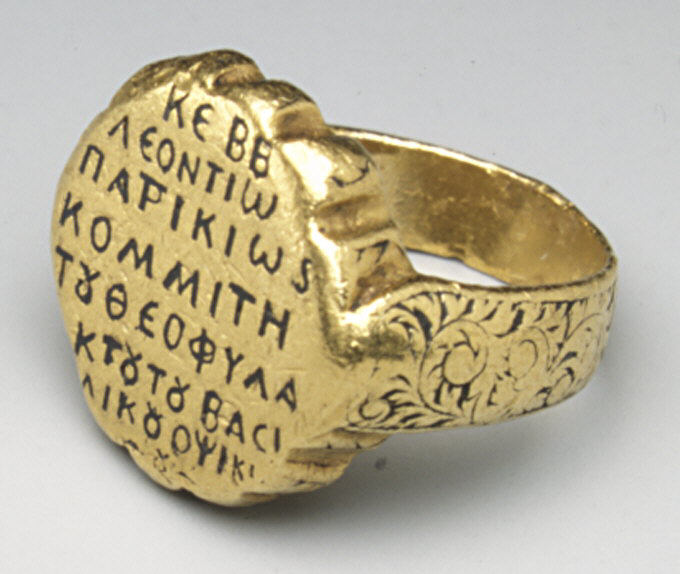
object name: ring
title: Ring of Leontios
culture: byzantine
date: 1000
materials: gold, niello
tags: greek